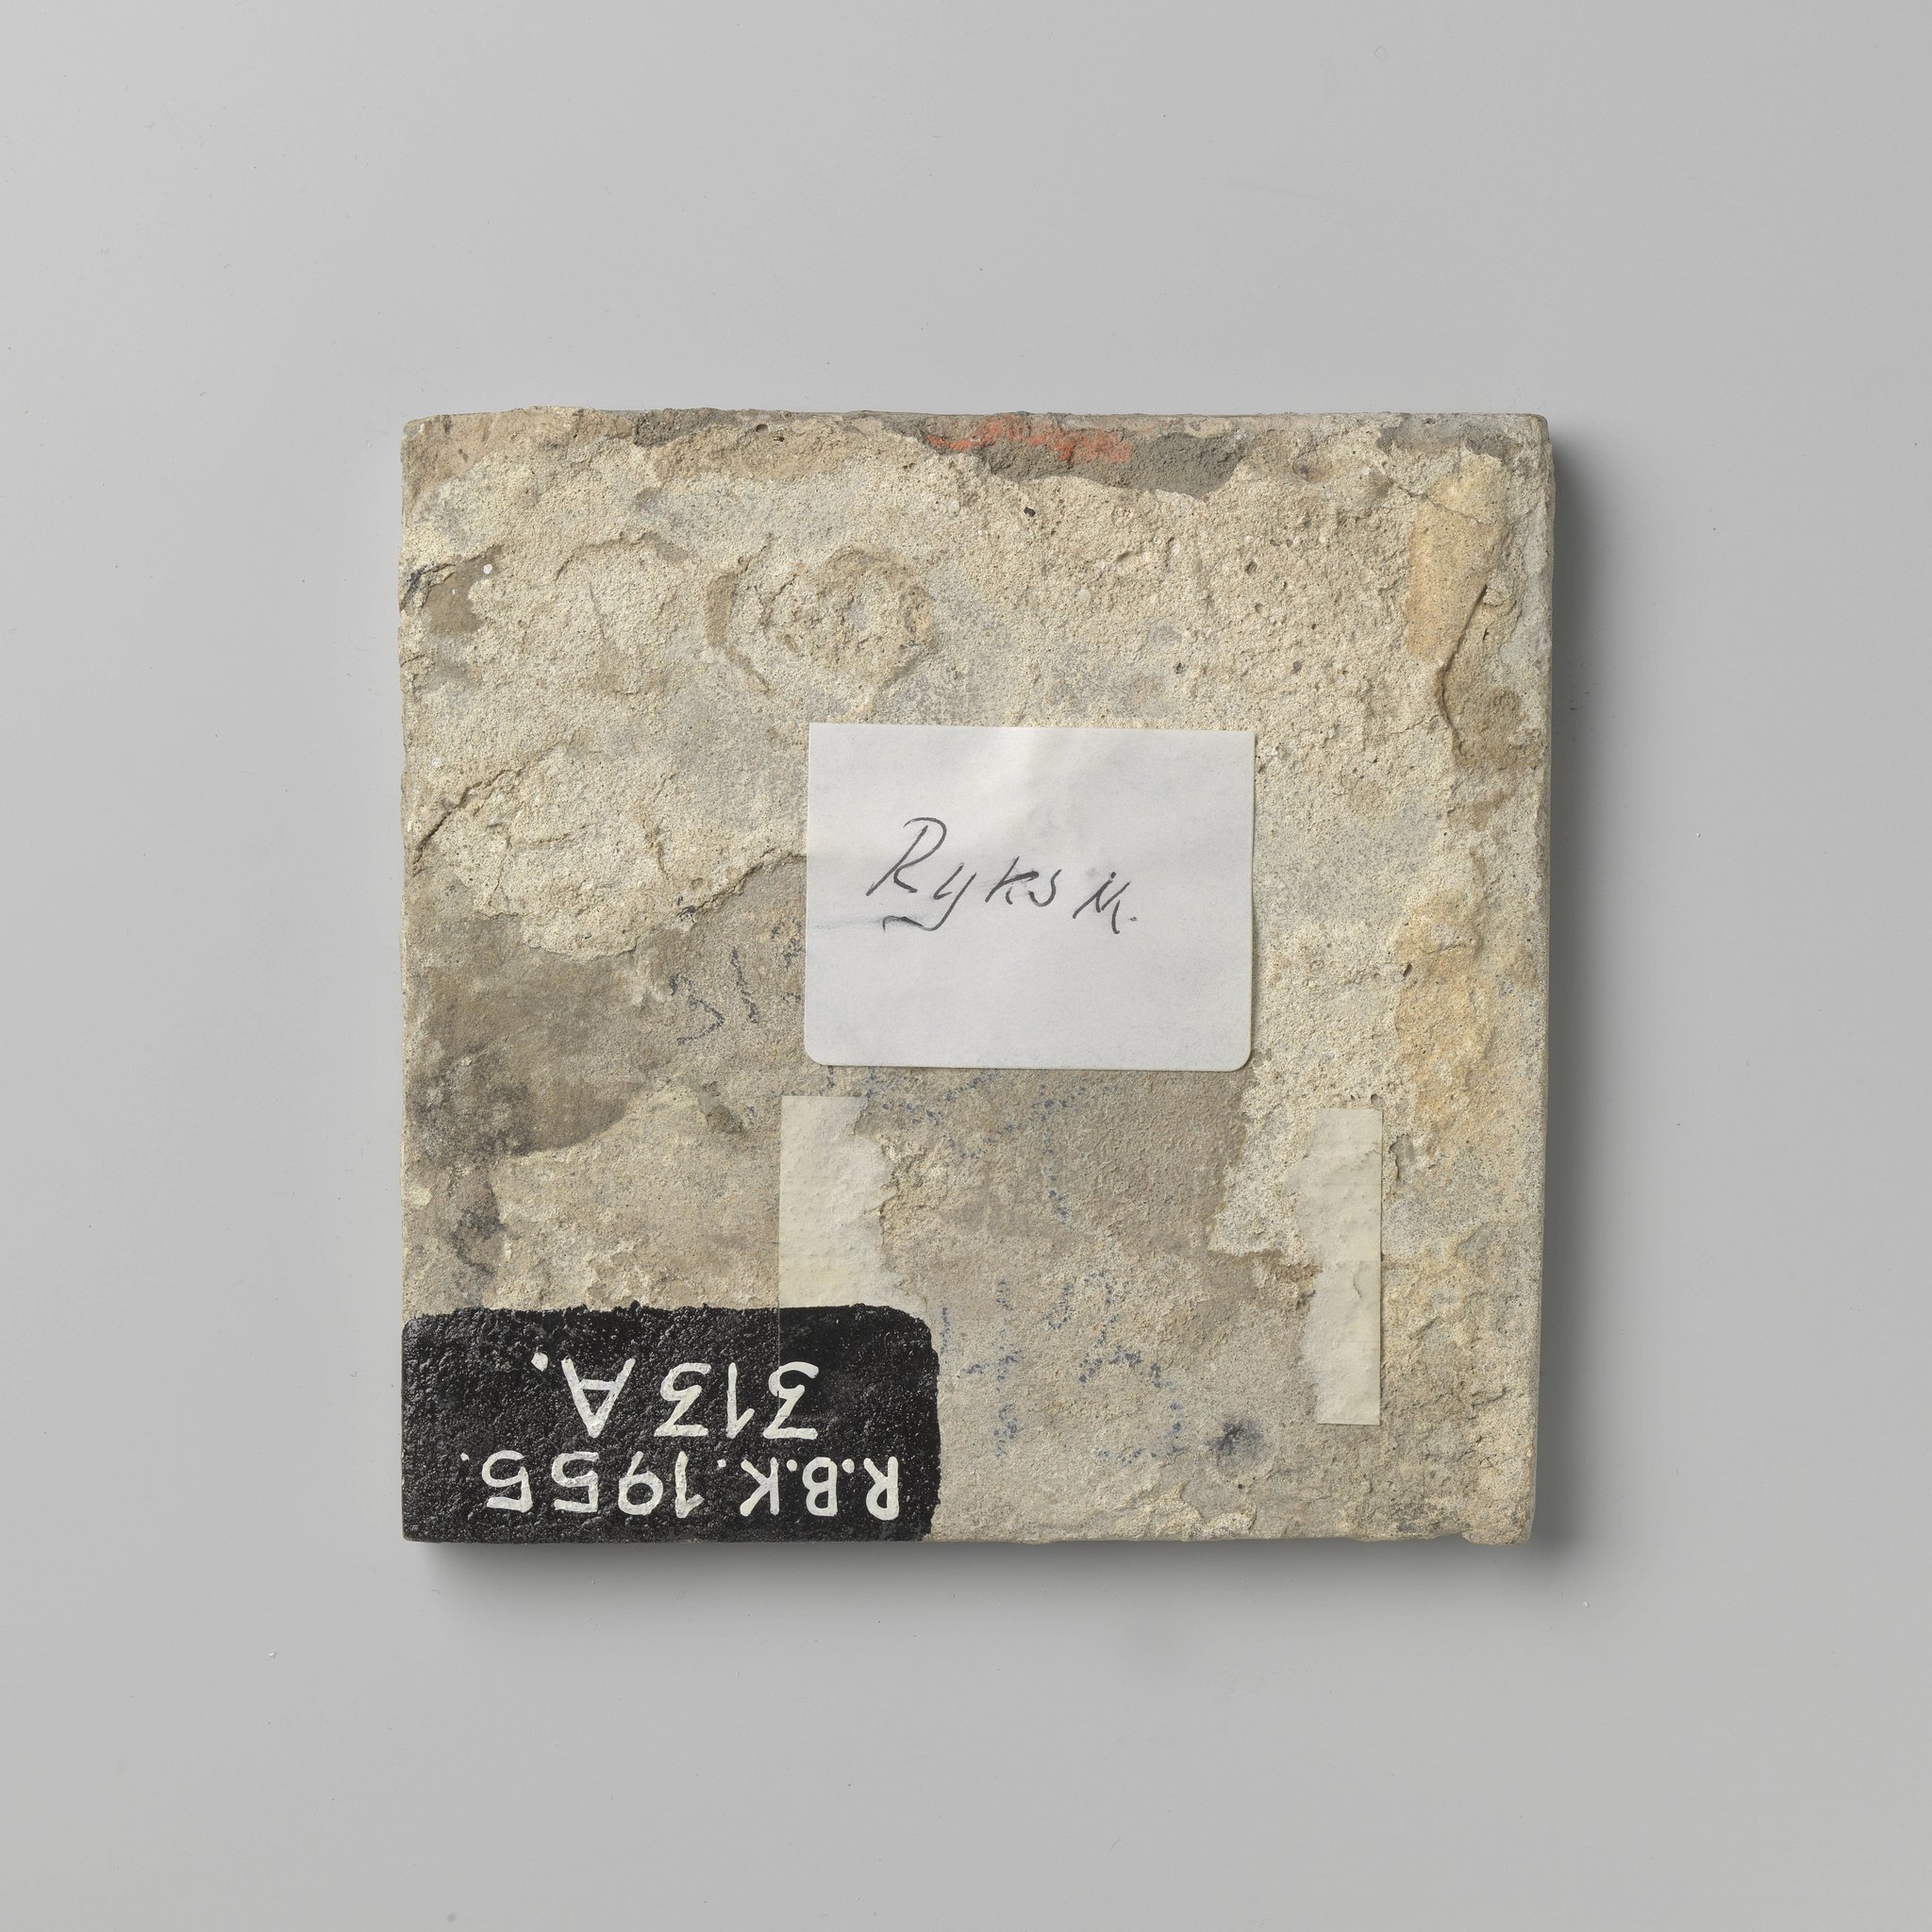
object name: tile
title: Tegel met stilleven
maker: Anonymous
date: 1700-1750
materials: earthenware, glaze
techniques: maiolica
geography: netherlands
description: Tegel met een blauw geschilderd stilleven van een vaas met bloemen en een vogel. Op de achtergrond, een buikvormige pot. In de hoeken, een spinnetje.